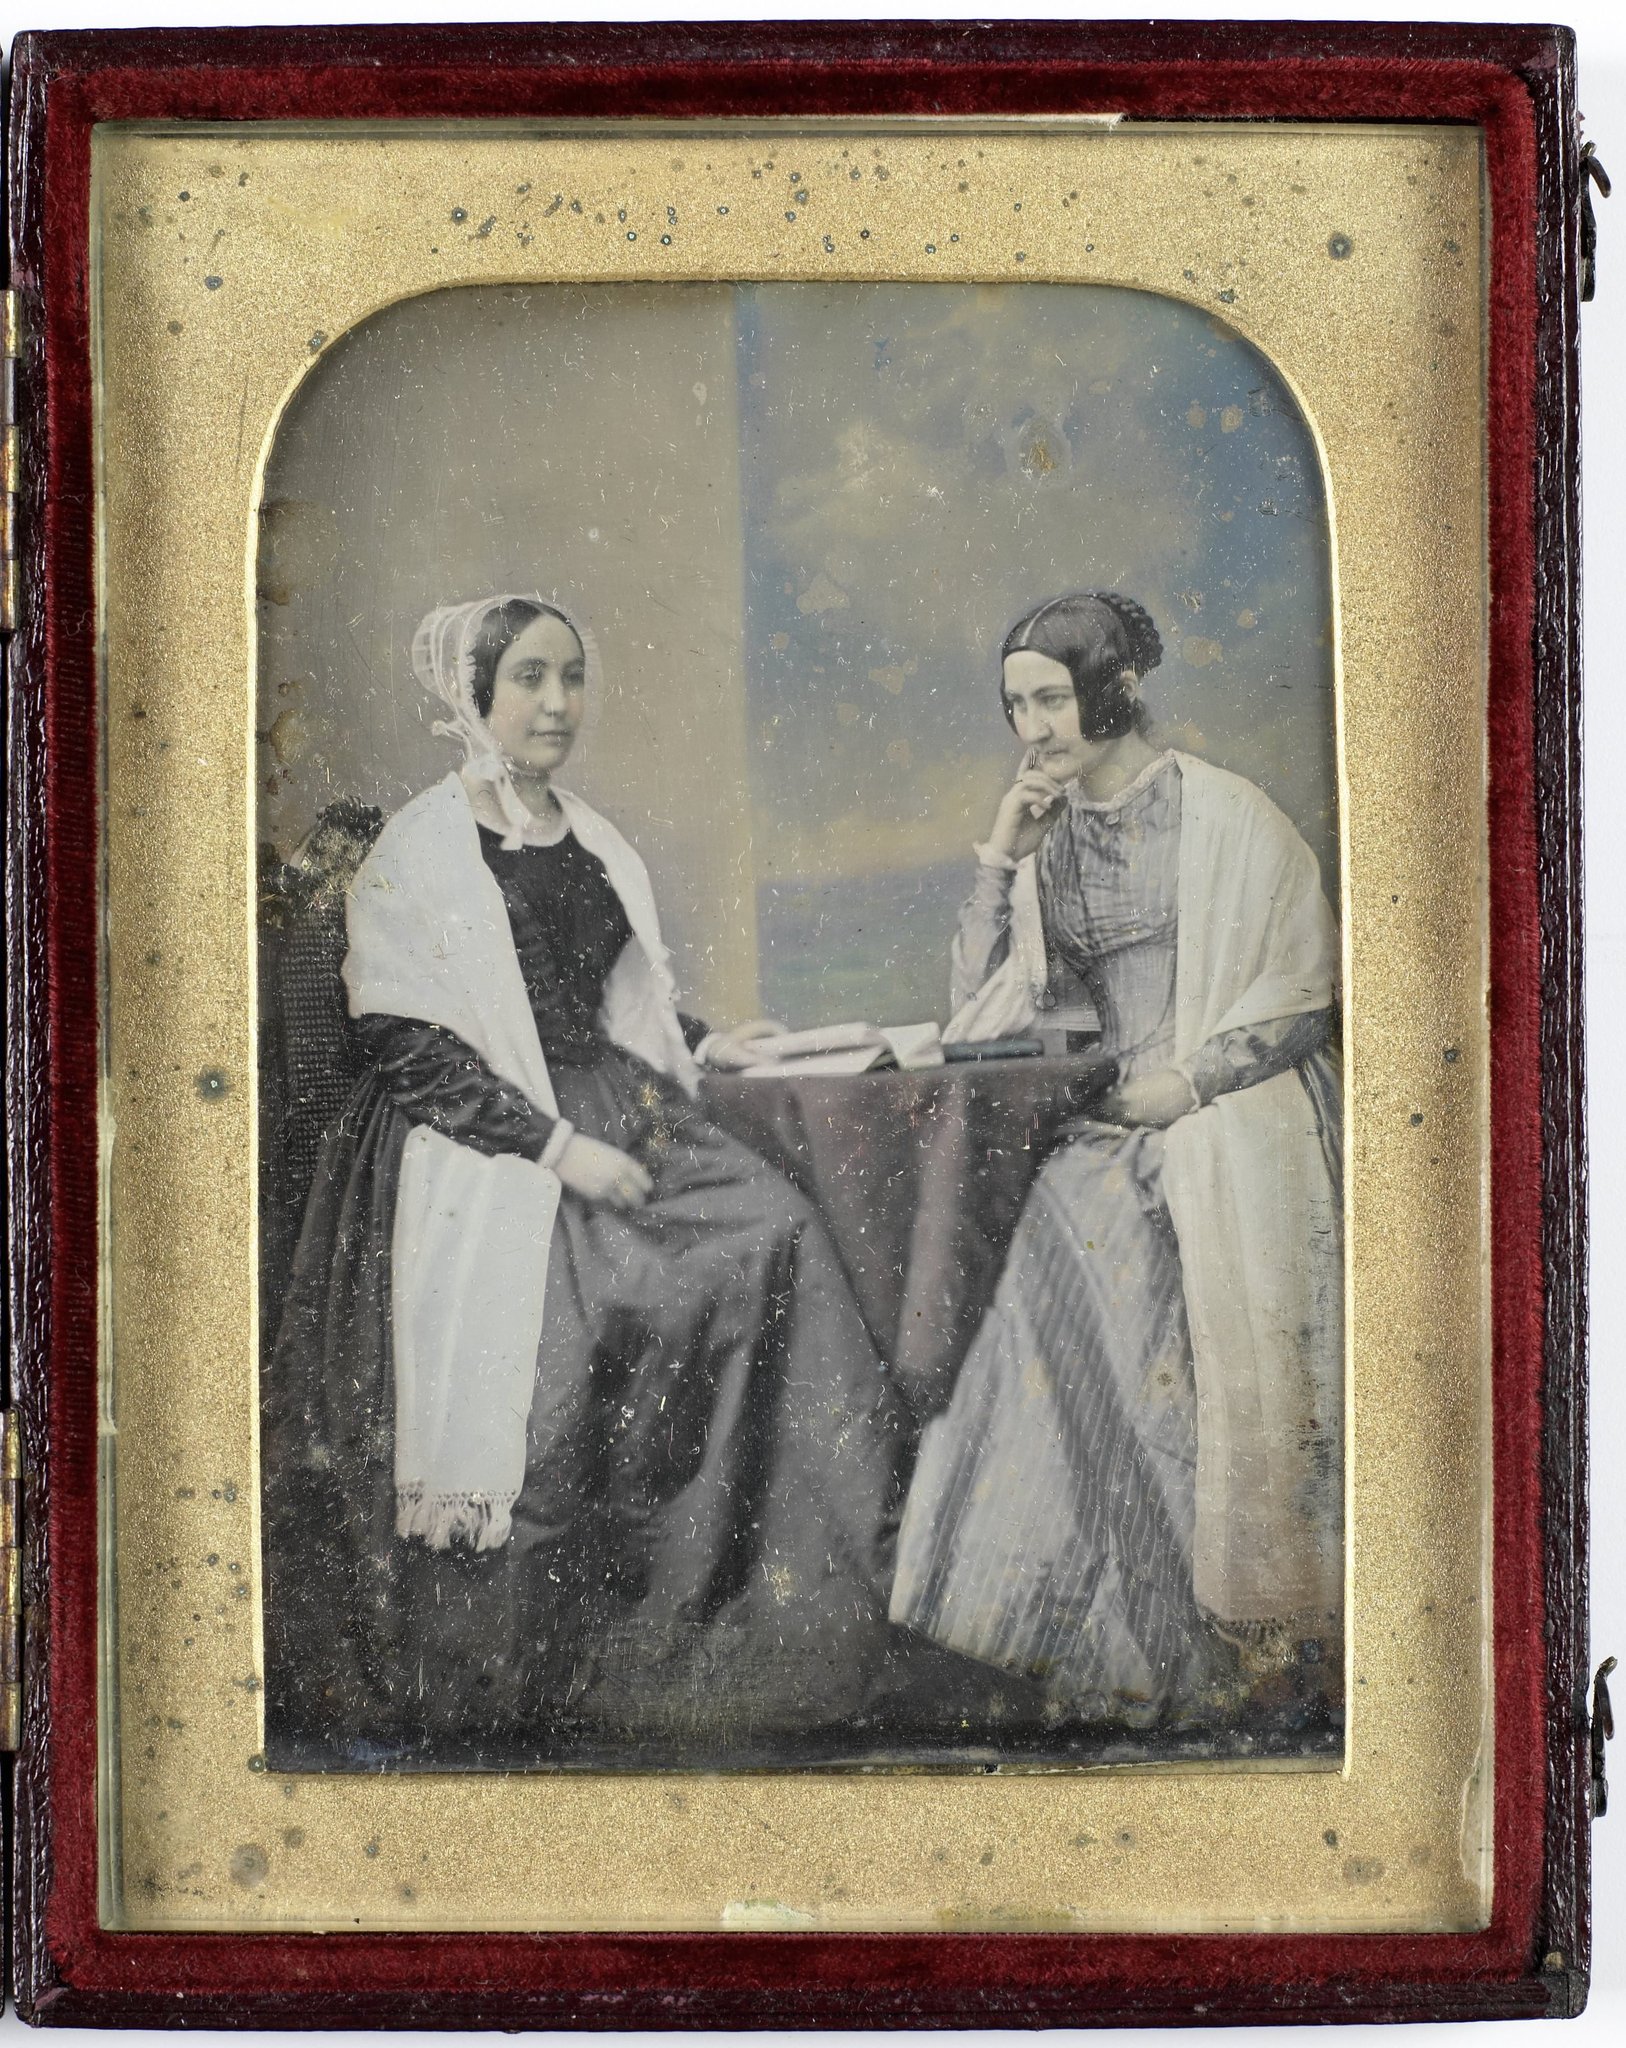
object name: photograph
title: Portret van twee onbekende vrouwen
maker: Anonymous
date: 1840-1860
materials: copper, glass, leather, velvet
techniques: daguerreotype, hand coloring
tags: adult woman, historical persons